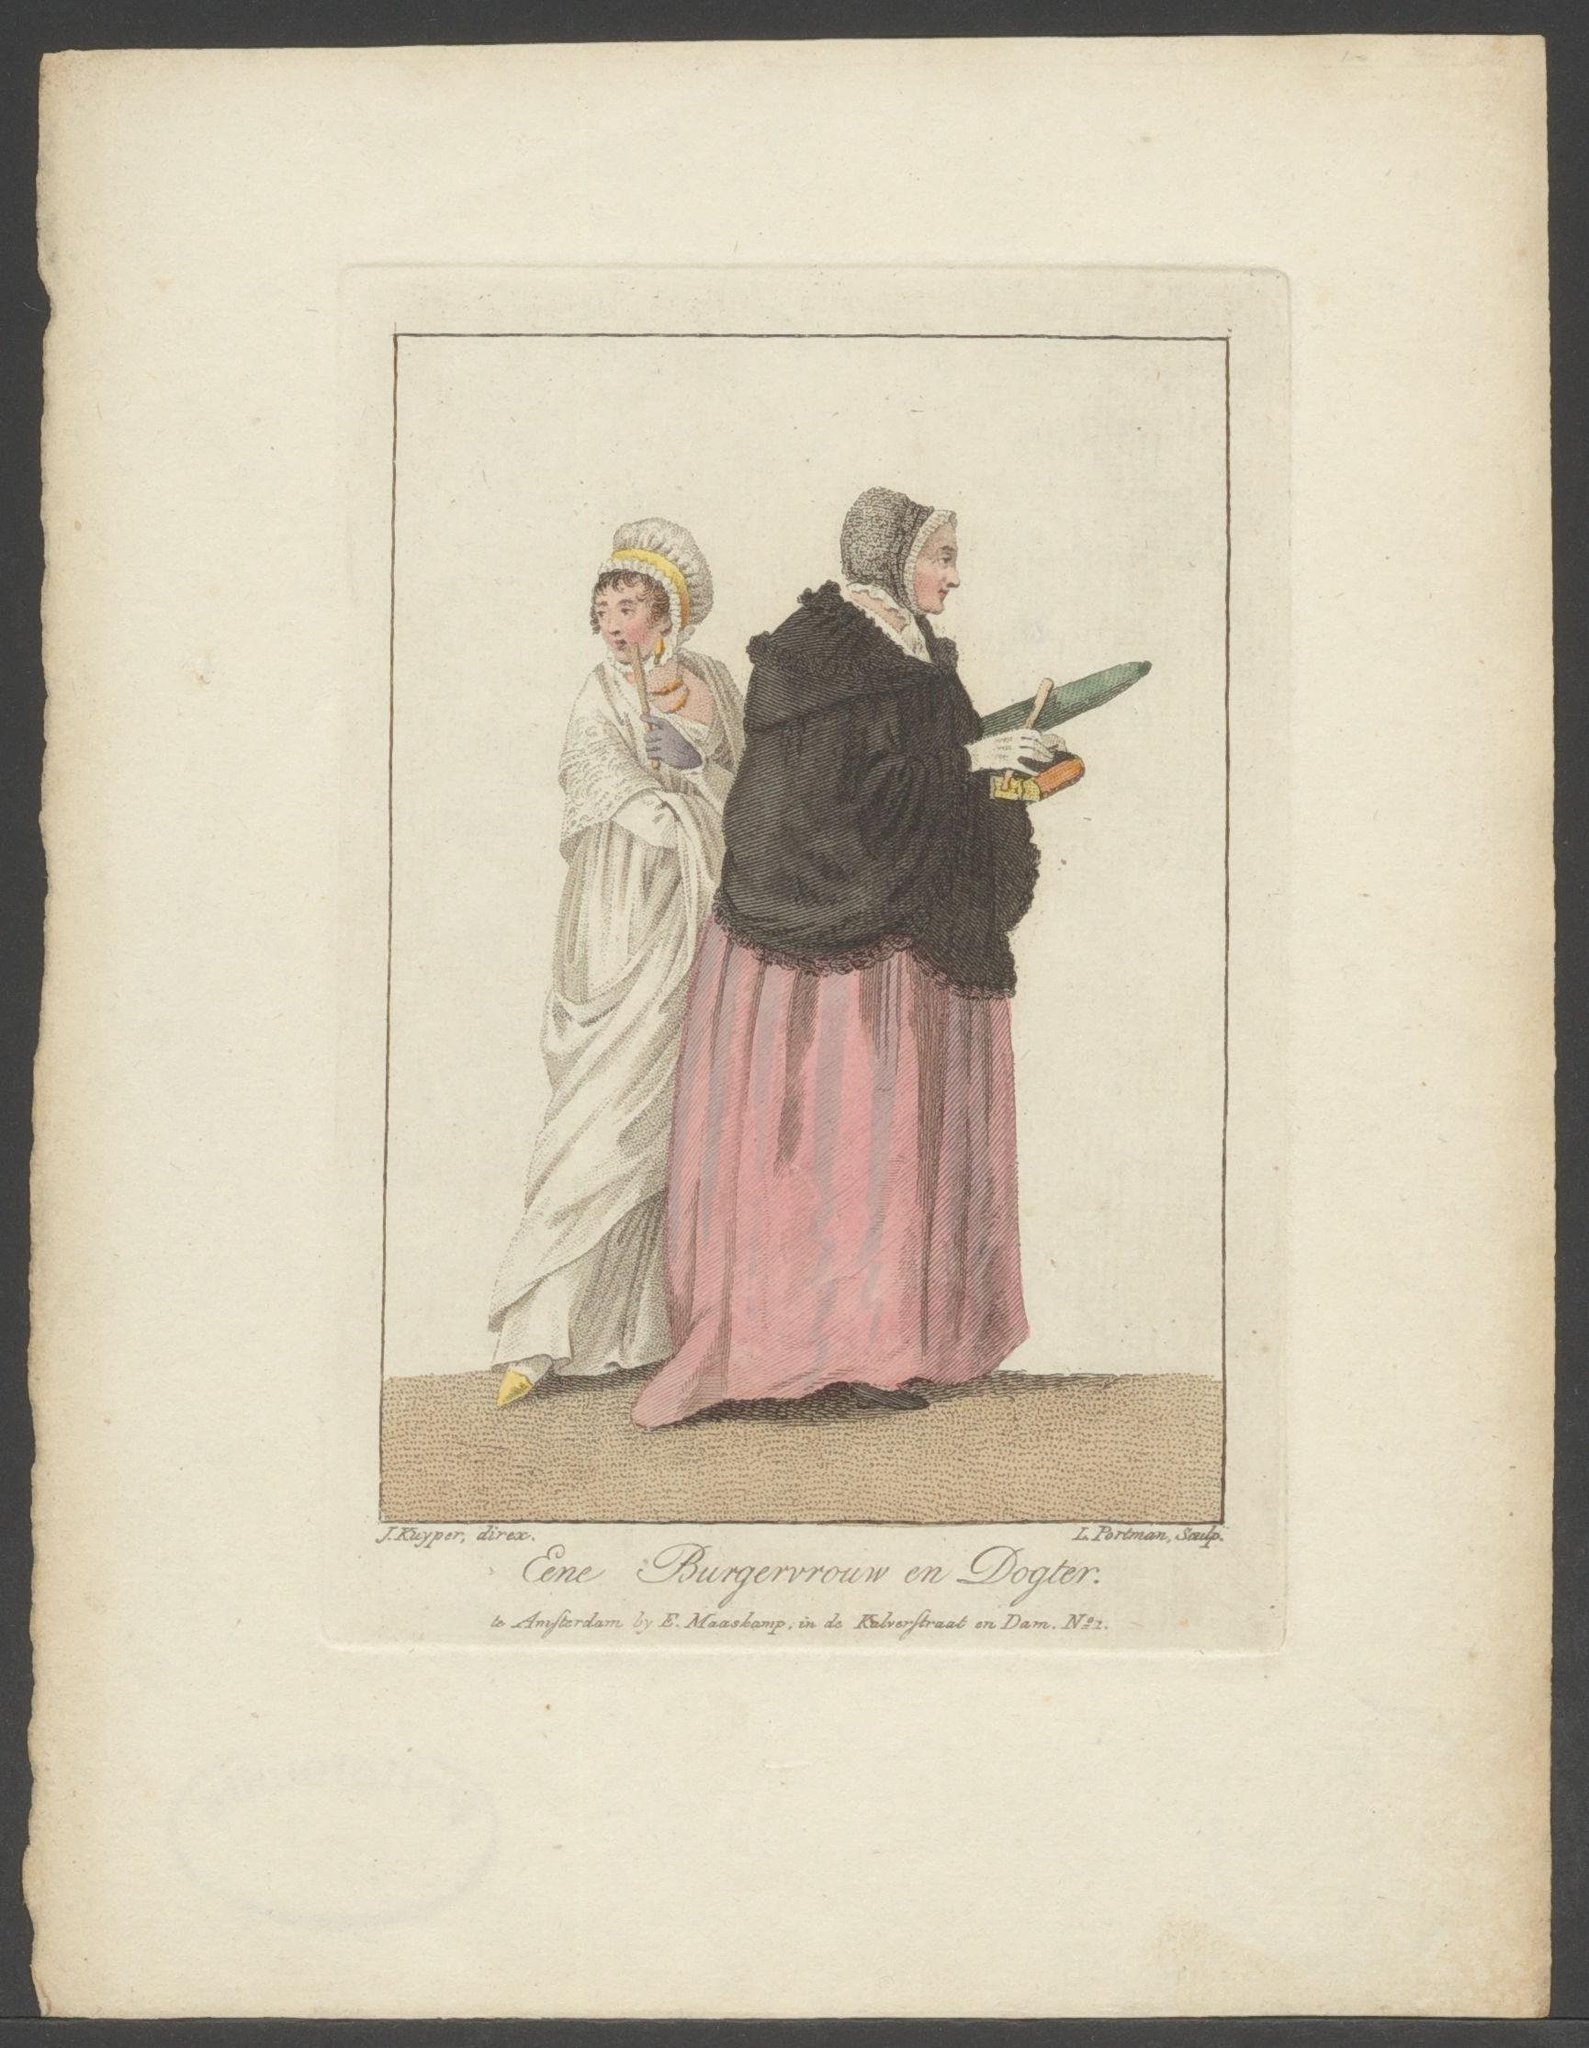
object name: costume print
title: Une Bourgeoise d'Amsterdam avec sa fille, allant à l'église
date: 1813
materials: paper, watercolor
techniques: etching, hand coloring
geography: amsterdam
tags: going to church, folk costume, regional costume, mother and daughter(s) (family group), clothes, costume, amsterdam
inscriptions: collector's mark: Lugt 1641, collector's mark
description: Een burgervrouw en haar dochter wandelen naar de kerk. De vrouw met een bijbel, en haar dochter met een waaier in de hand kijkt achterom. Bij de prent zit ook een blad met de Franse titel. Onderdeel van de verkleinde kopieën uit 1806 naar de platen van Nederlandse klederdrachten uit de jaren 1803-1807. Onderwerpsrubrieken binnen de Atlas Zeden en Gewoonten: De Kleeding, Volkskleederdracht.